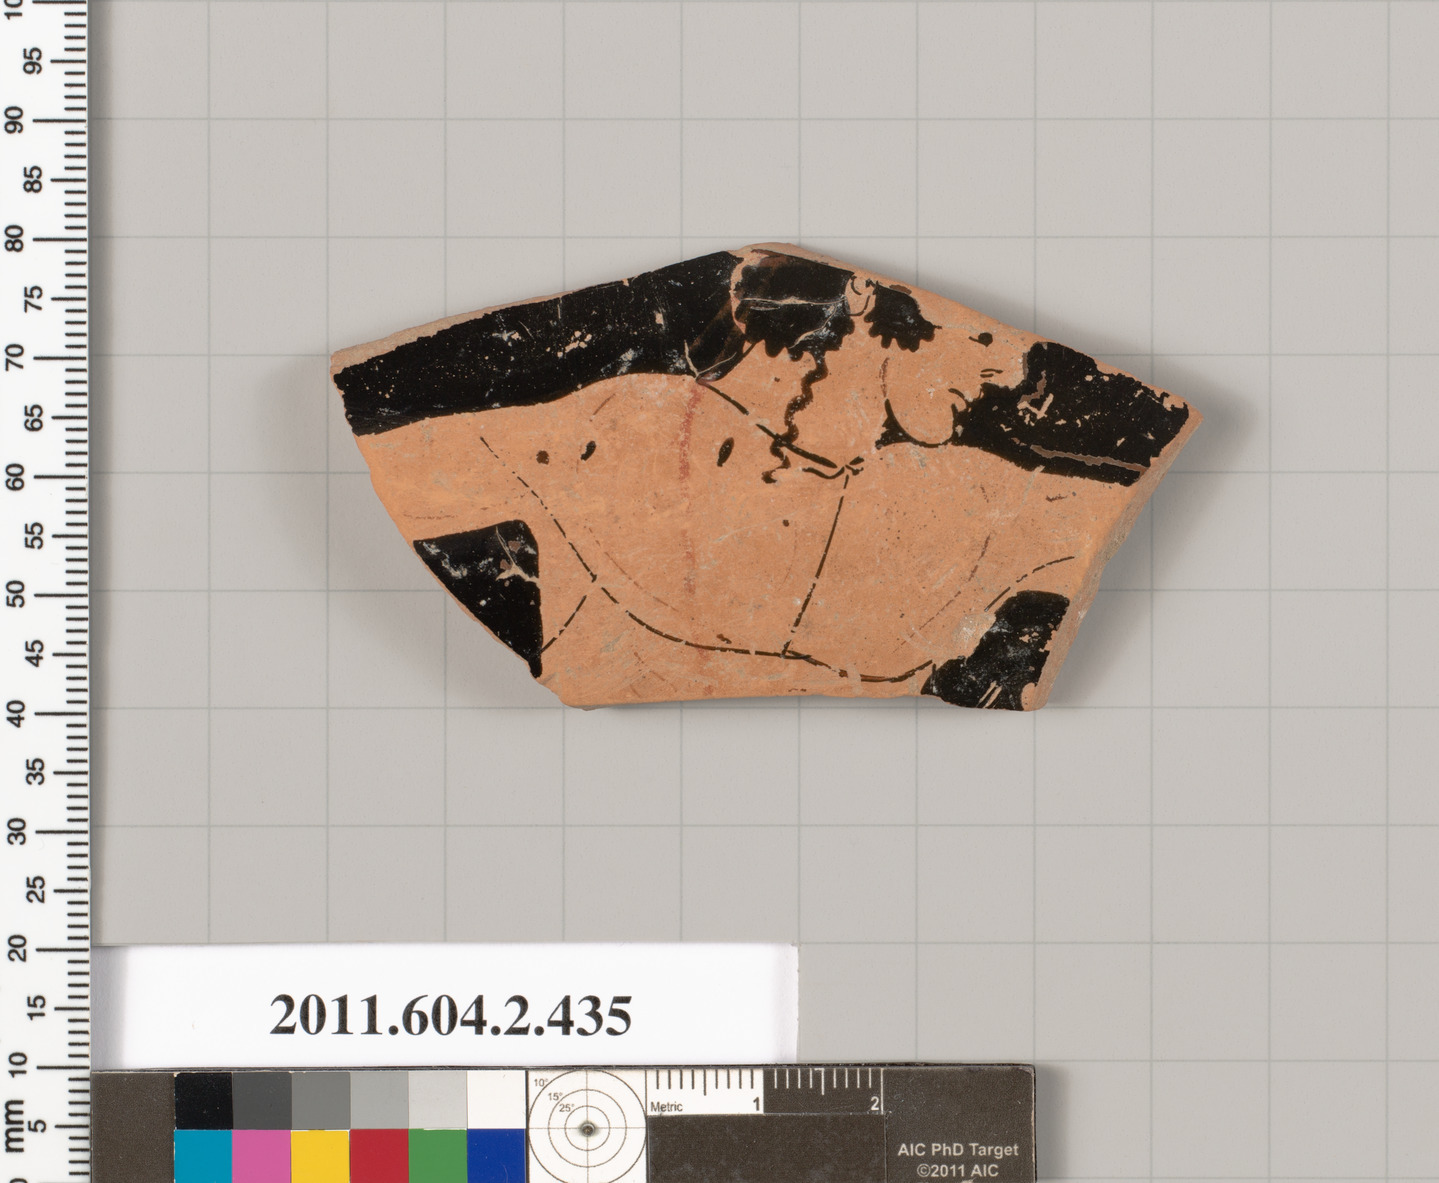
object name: column krater fragment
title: Terracotta fragment of a column-krater (bowl for mixing wine and water)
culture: greek, attic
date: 460-440 BCE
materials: terracotta